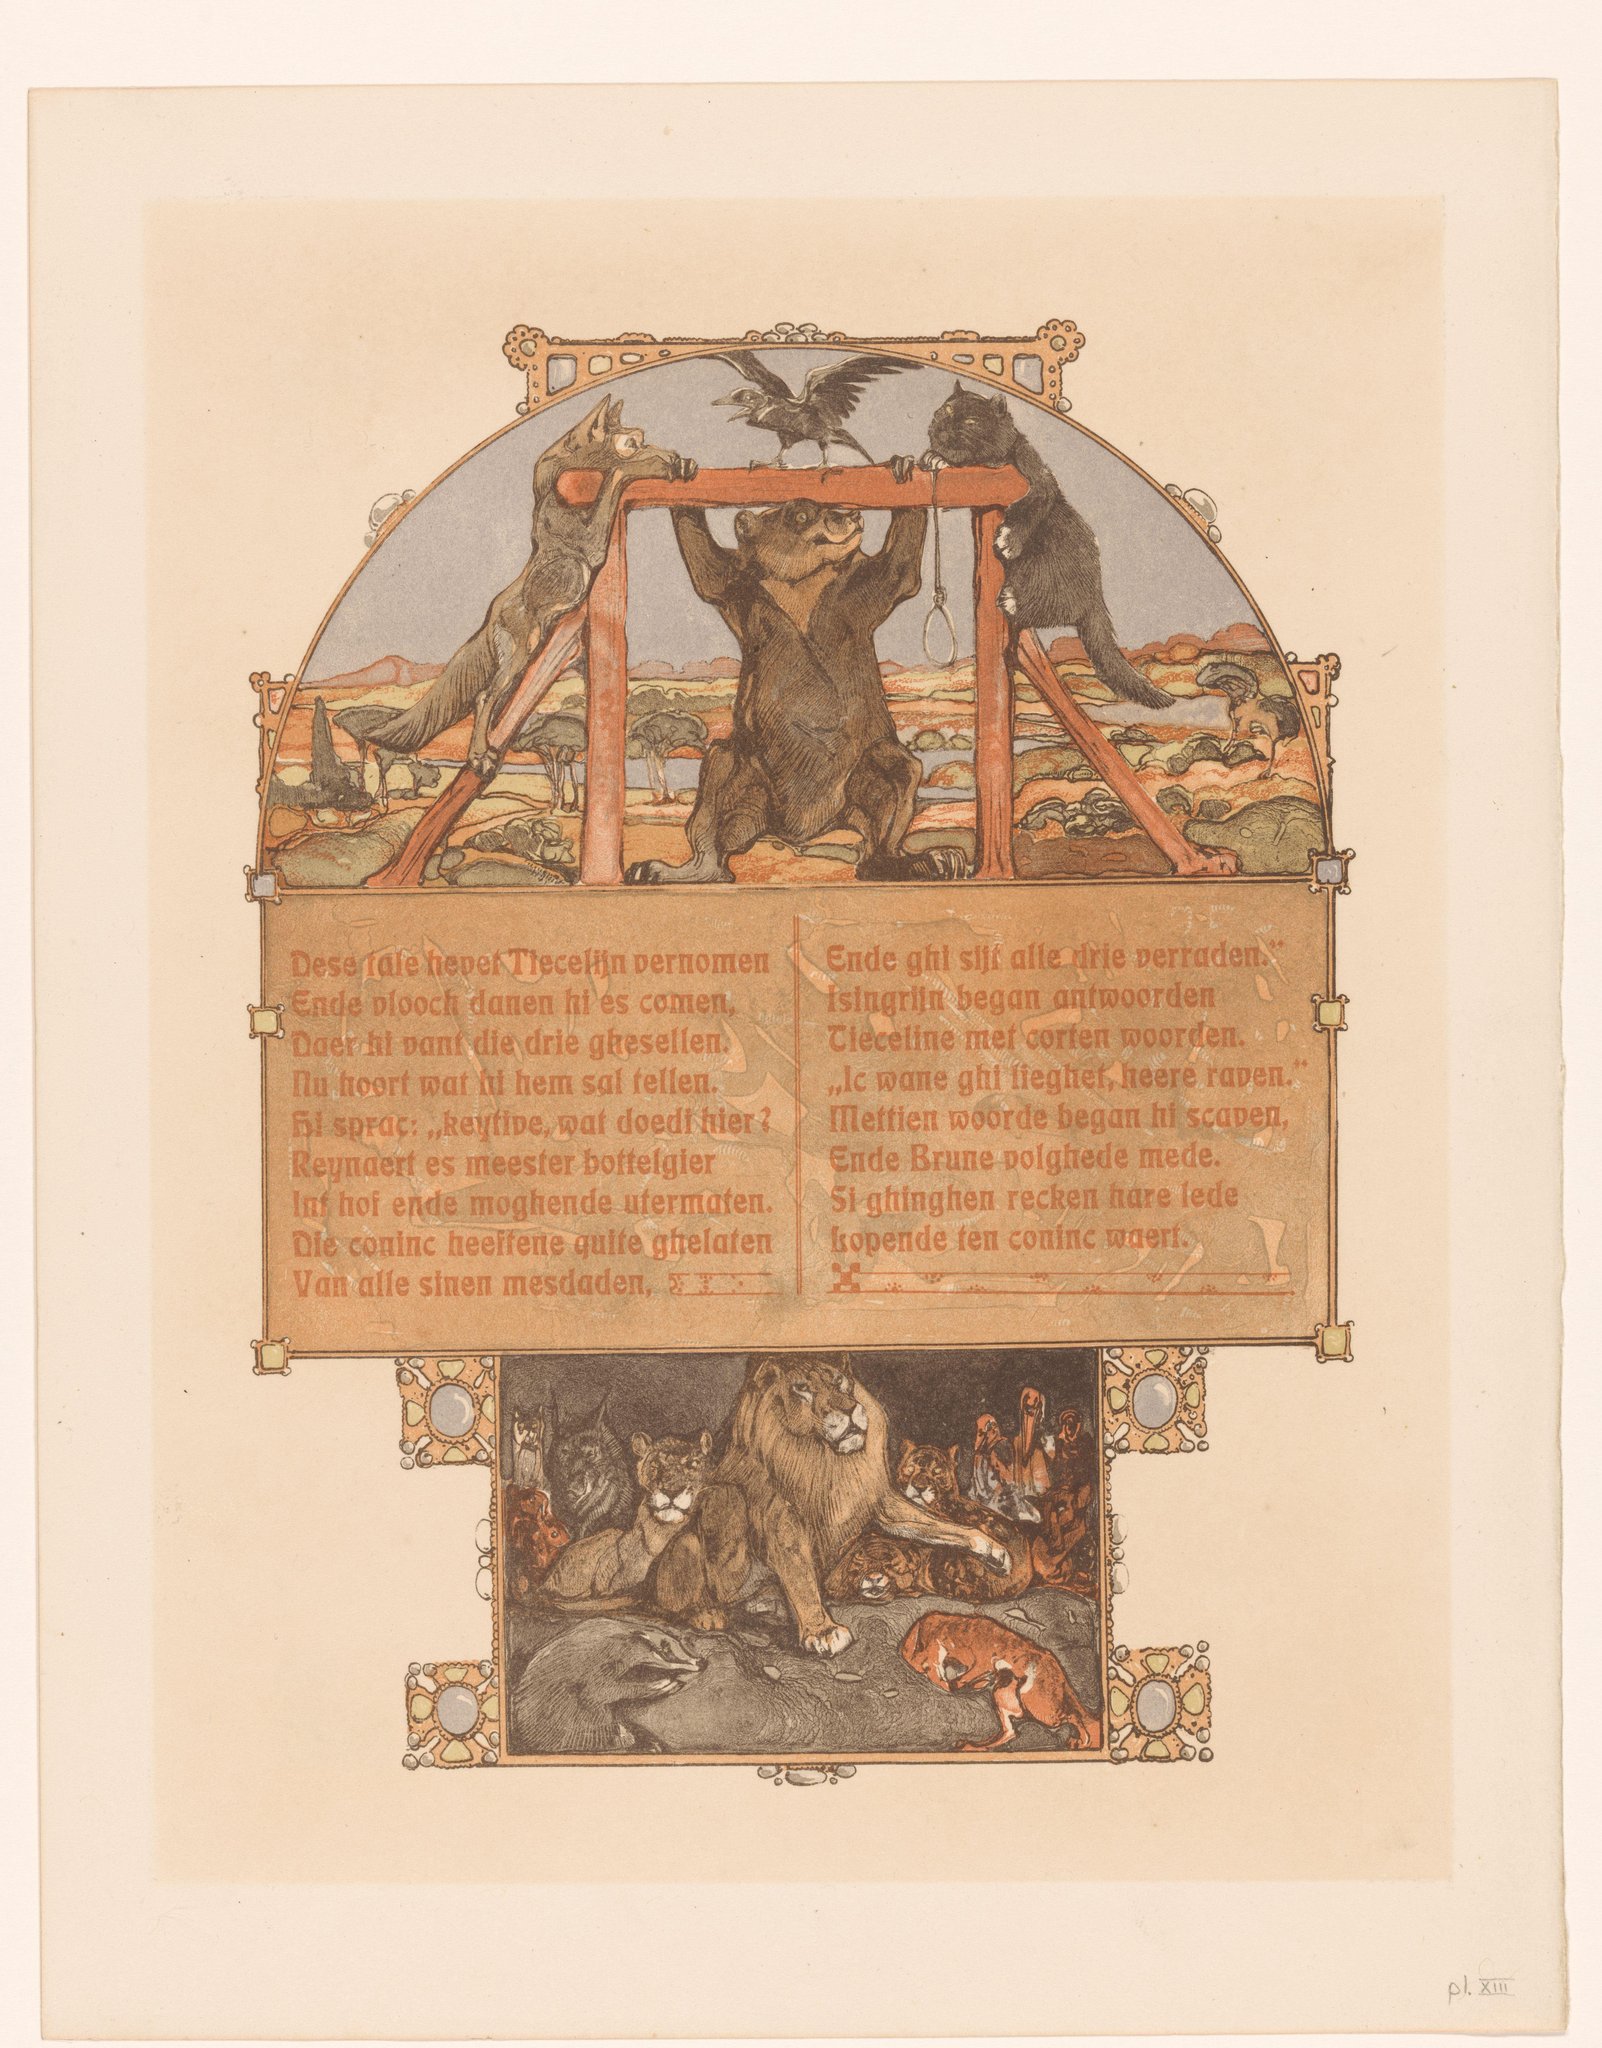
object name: book illustration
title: Vos (Reinaert), beer (Bruun), kat (Tybeert) en raaf (Tiecelijn) bij galg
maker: bernard willem wierink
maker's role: draughtsman, print maker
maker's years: 1856-1939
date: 1910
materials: paper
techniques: lithograph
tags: fable of reynard the fox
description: Prent gebruikt in: Streuvels, Stijn (Frank Lateur). Reinaert de Vos naar verschillende uitgaven van het middeleeuwsche epos. Amsterdam: L.J. Veen, 1910.